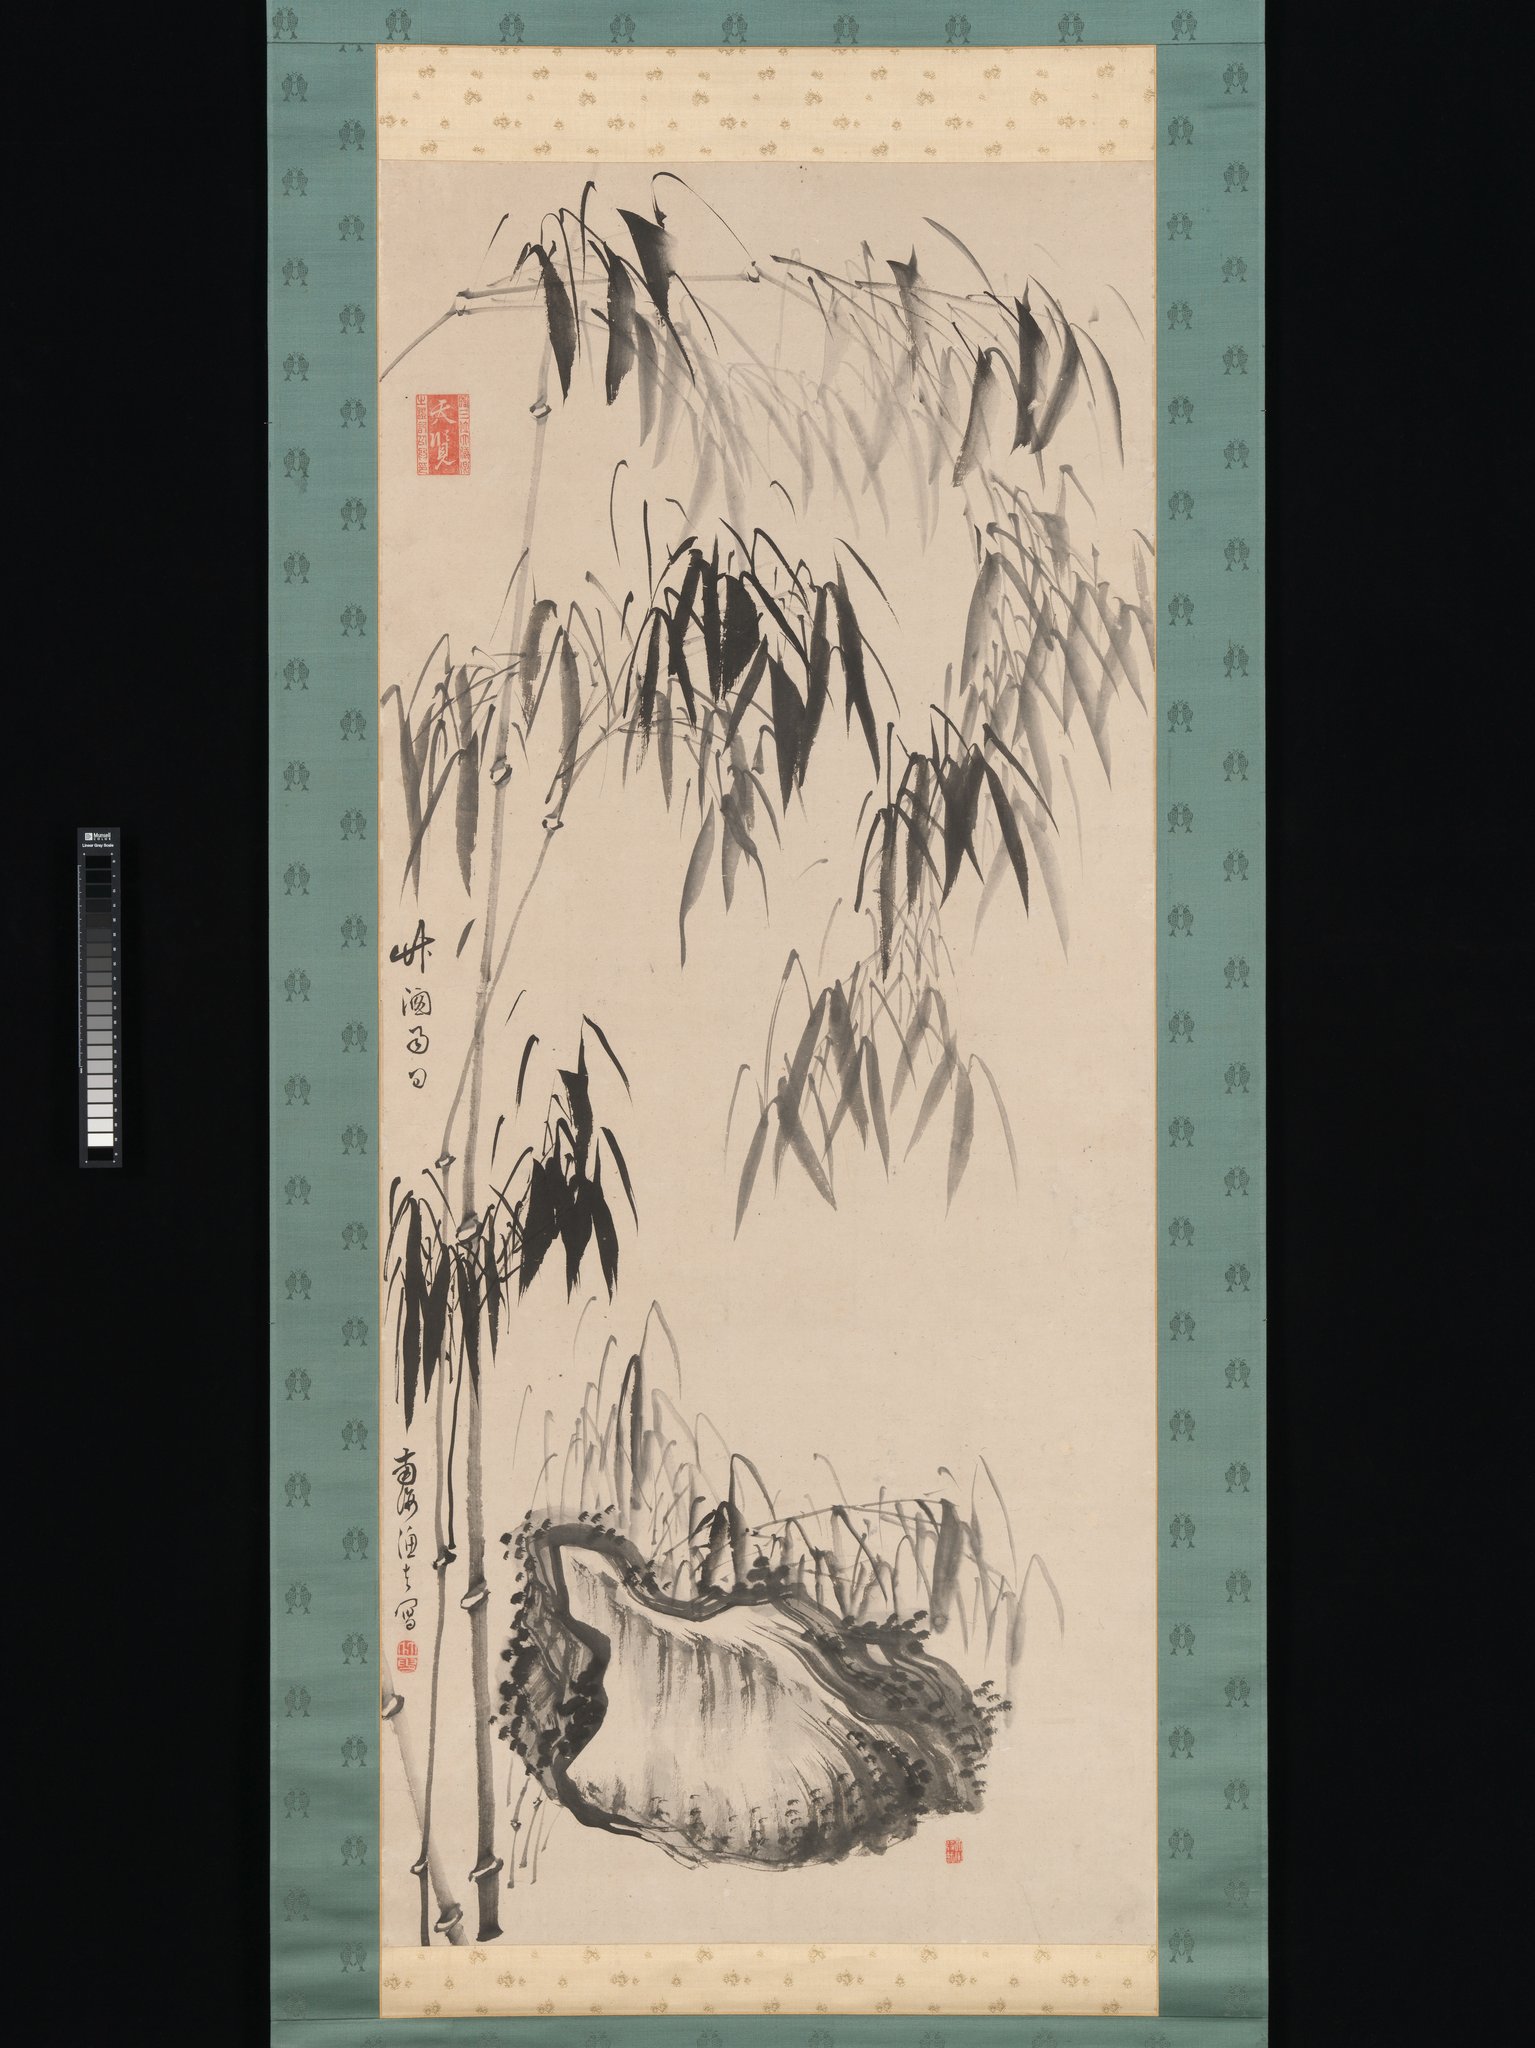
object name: hanging scroll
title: Window onto Bamboo on a Rainy Day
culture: japanese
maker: gion nankai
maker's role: artist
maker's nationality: japanese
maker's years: 1677-1751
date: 1701-1750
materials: ink, paper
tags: bamboo